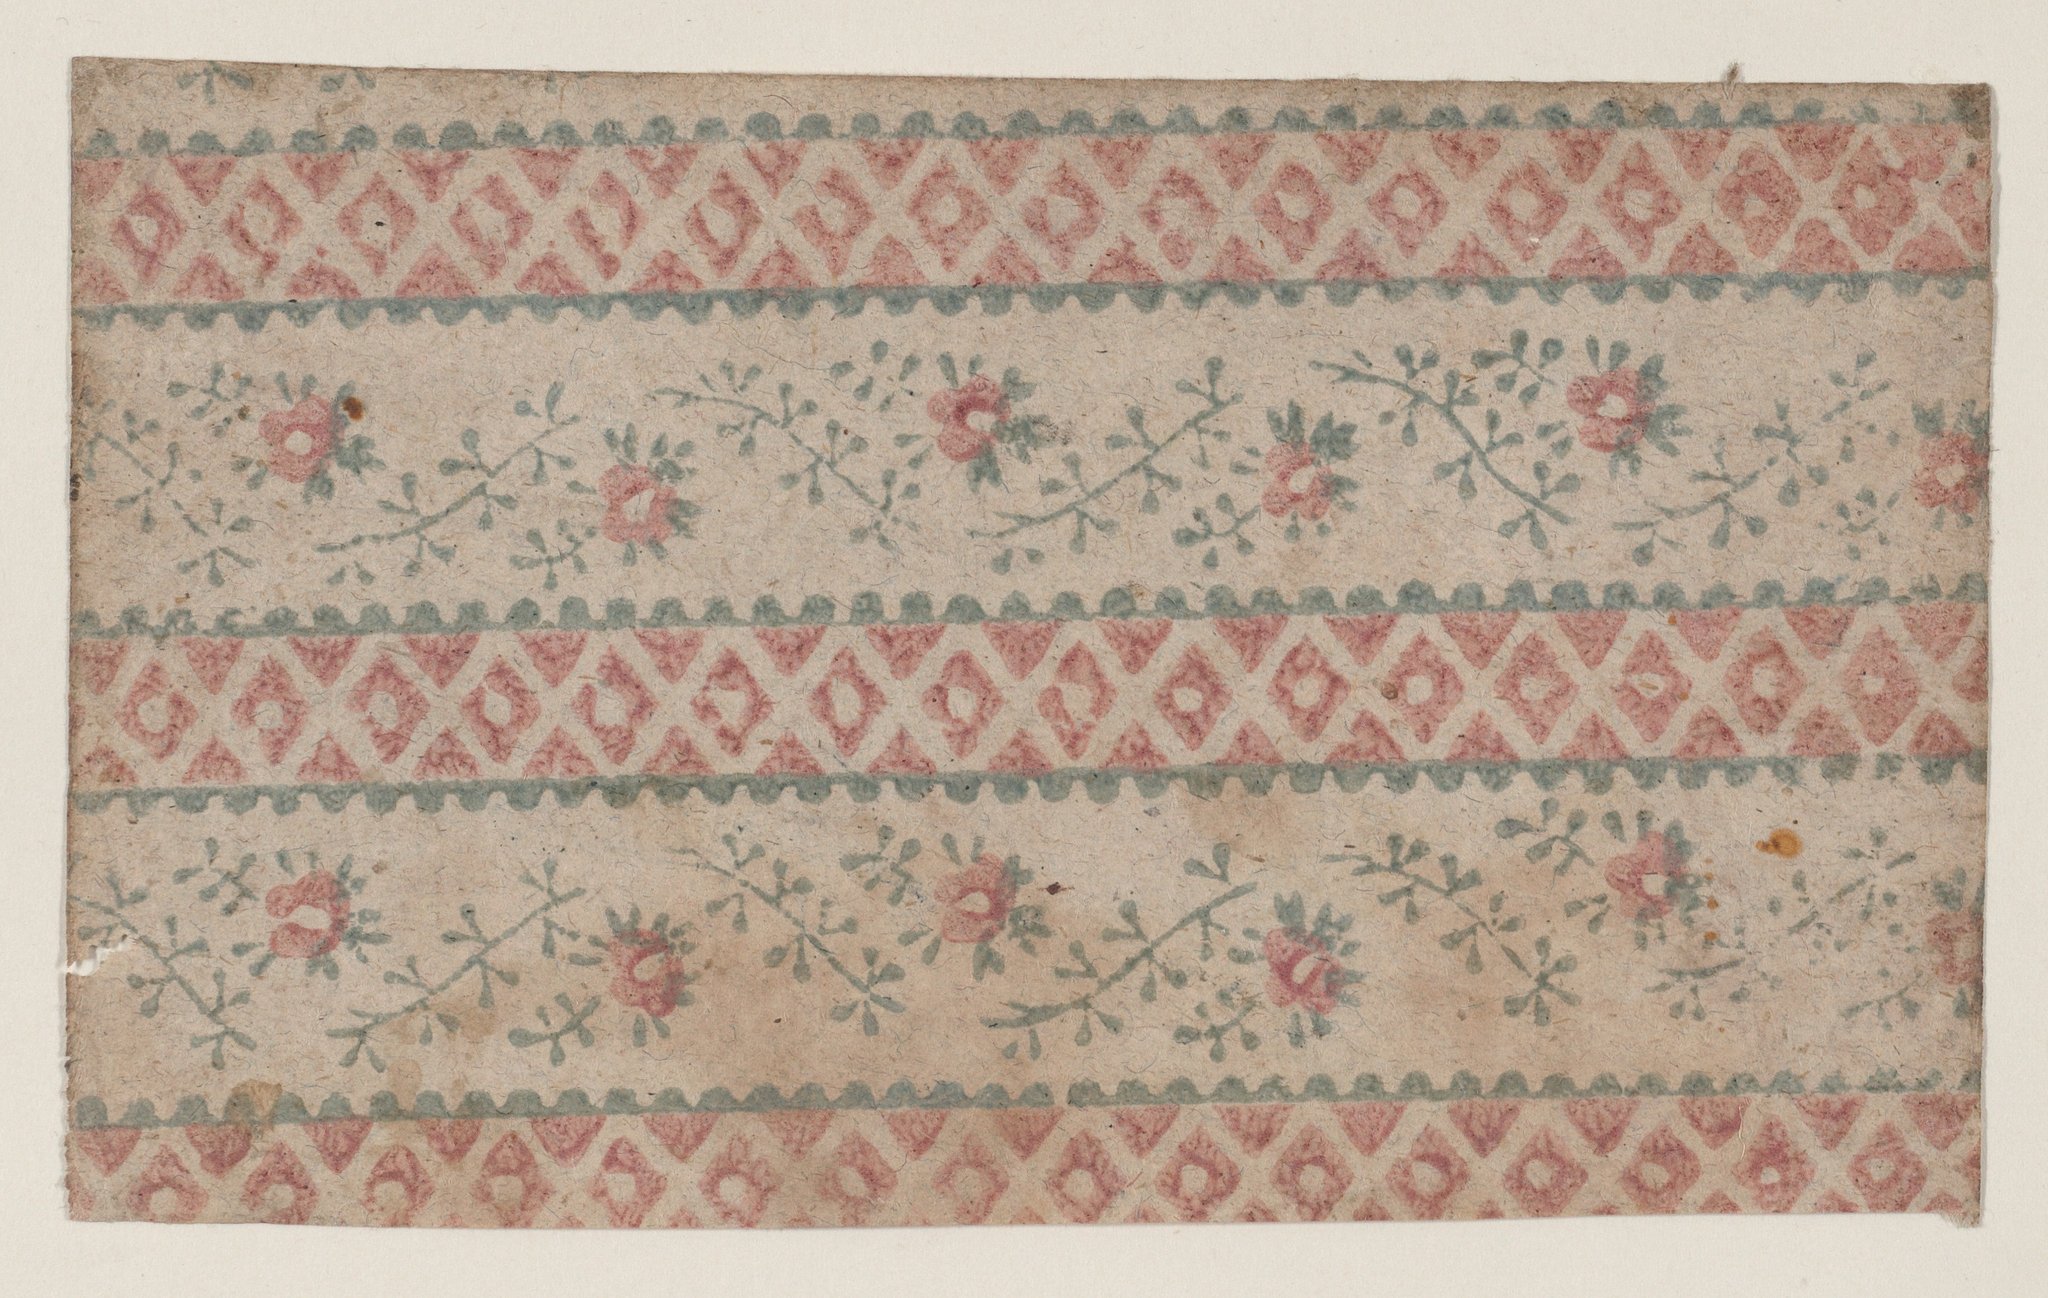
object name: print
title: Sheet with two borders with floral and stripe designs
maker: Anonymous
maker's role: artist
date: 1801-1900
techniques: relief print